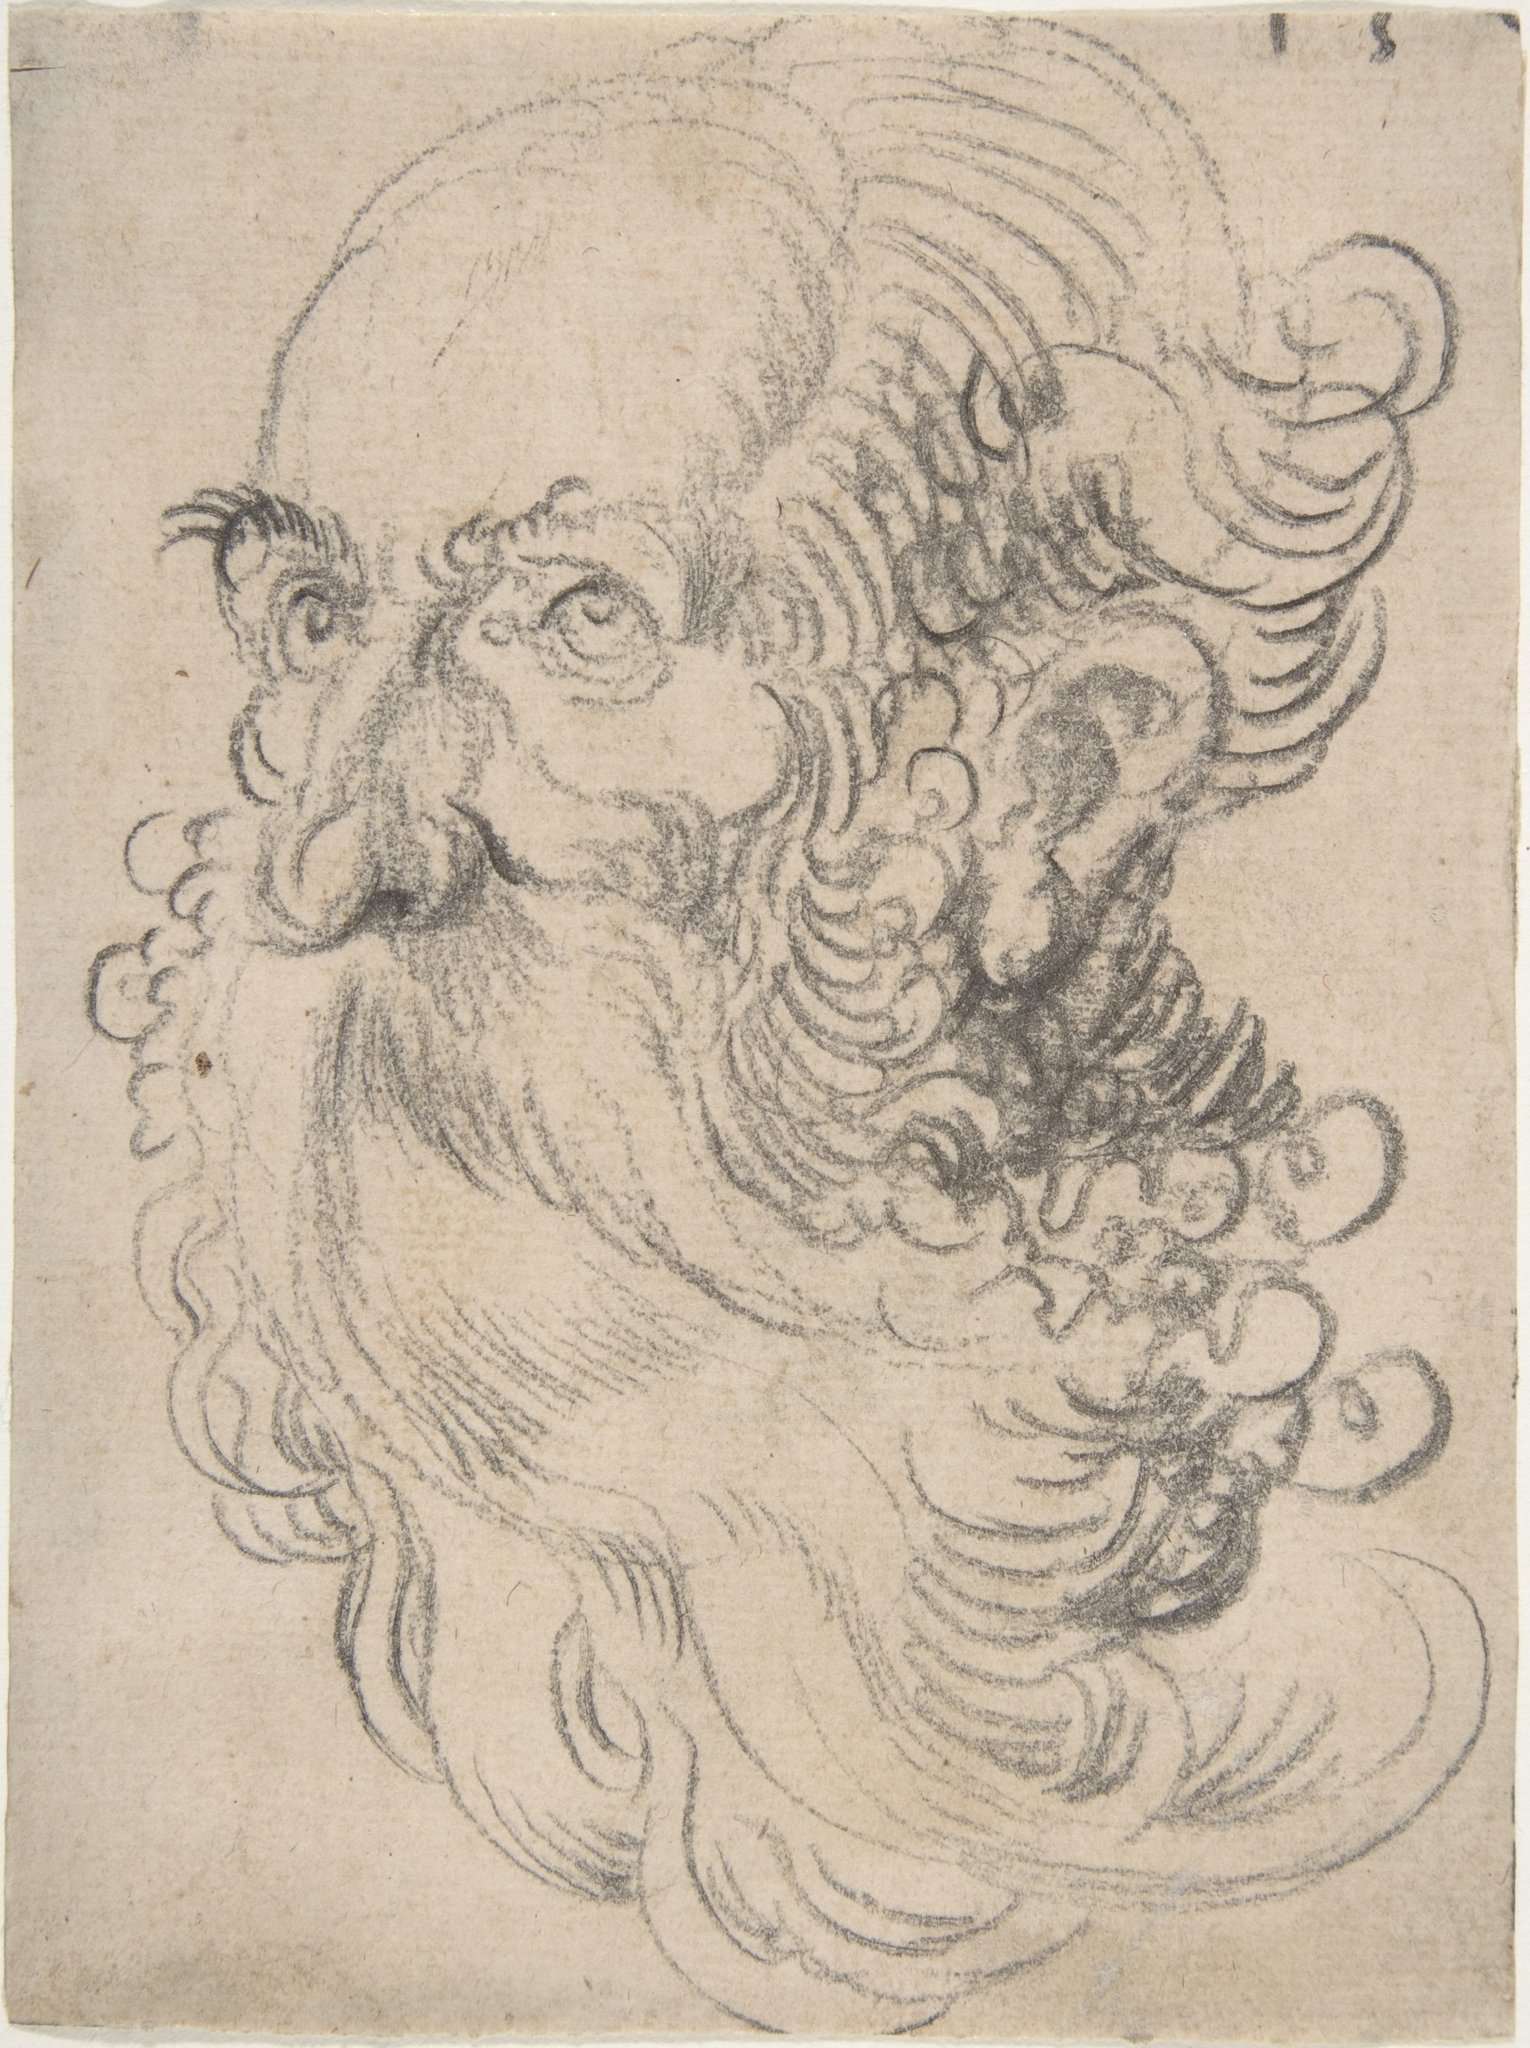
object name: drawing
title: Head of a Bearded Old Man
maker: wolfgang huber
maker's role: artist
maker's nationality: german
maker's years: 1485-1553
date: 1520-1529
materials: chalk, down, paper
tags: heads,men